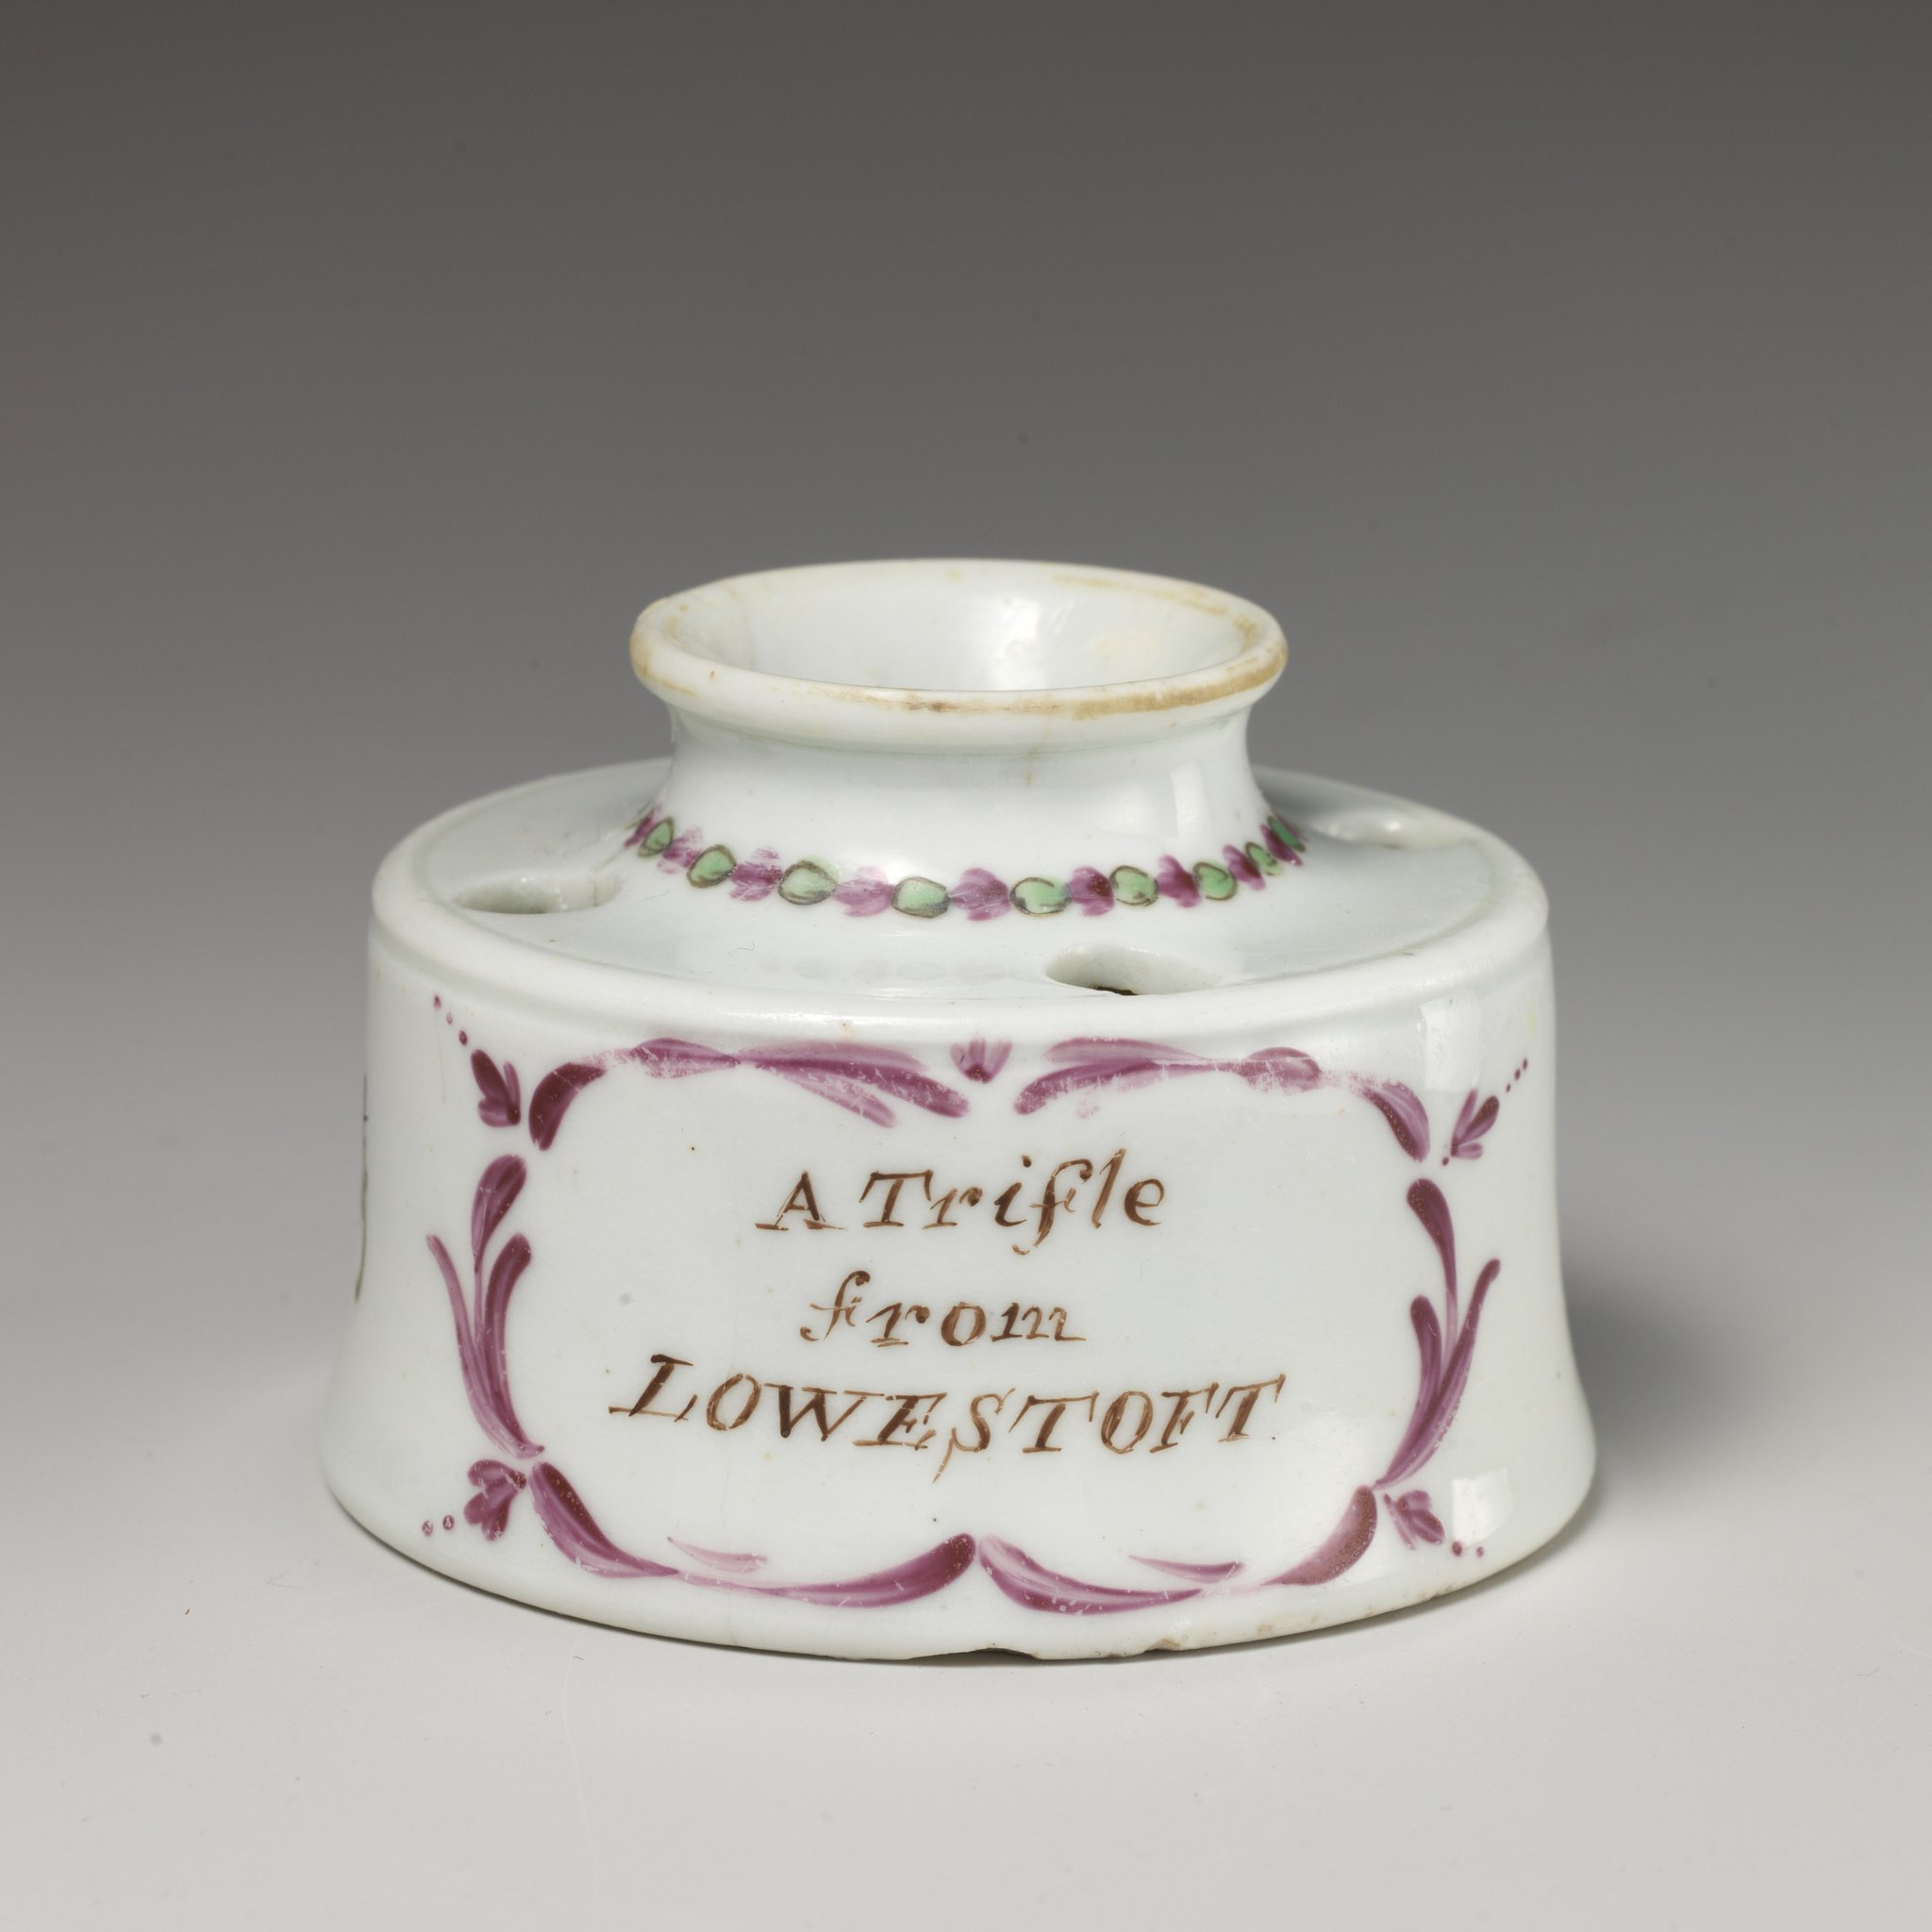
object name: inkstand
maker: lowestoft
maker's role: factory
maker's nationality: british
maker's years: 1757-1803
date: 1780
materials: soft paste porcelain